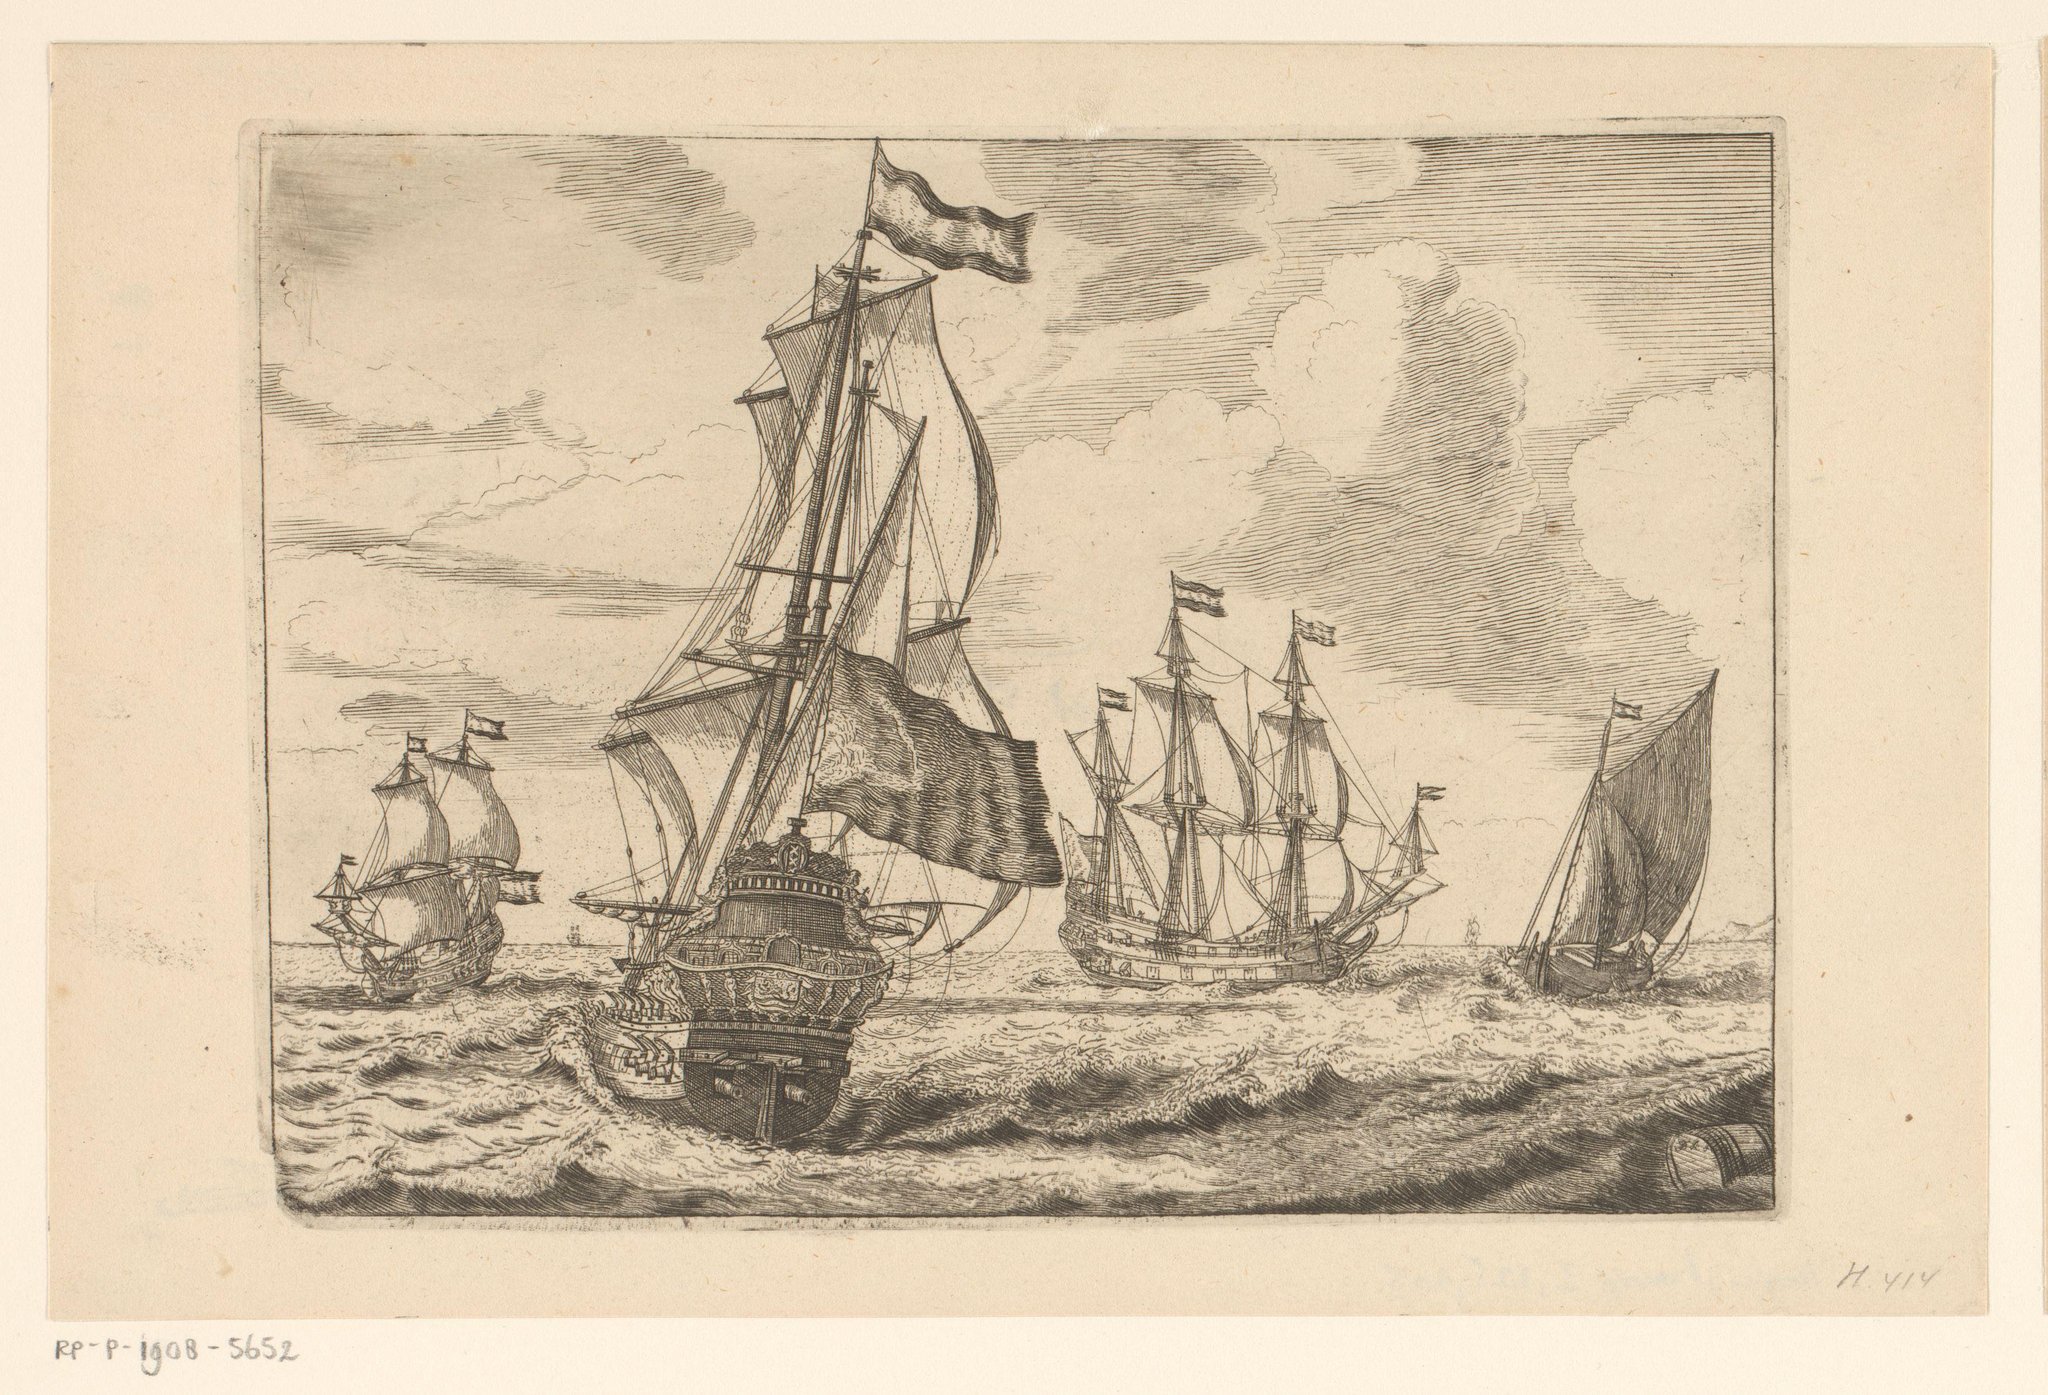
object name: print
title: Oorlogsschepen op zee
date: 1673-1709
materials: paper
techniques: etching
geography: northern netherlands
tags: sailing-ship, sailing-boat, sea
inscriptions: collector's mark: Lugt 2228, collector's mark: Lugt 2162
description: Verschillende zeilschepen, waaronder een driemaster op zee. Rechtsvoor drijft een ton.